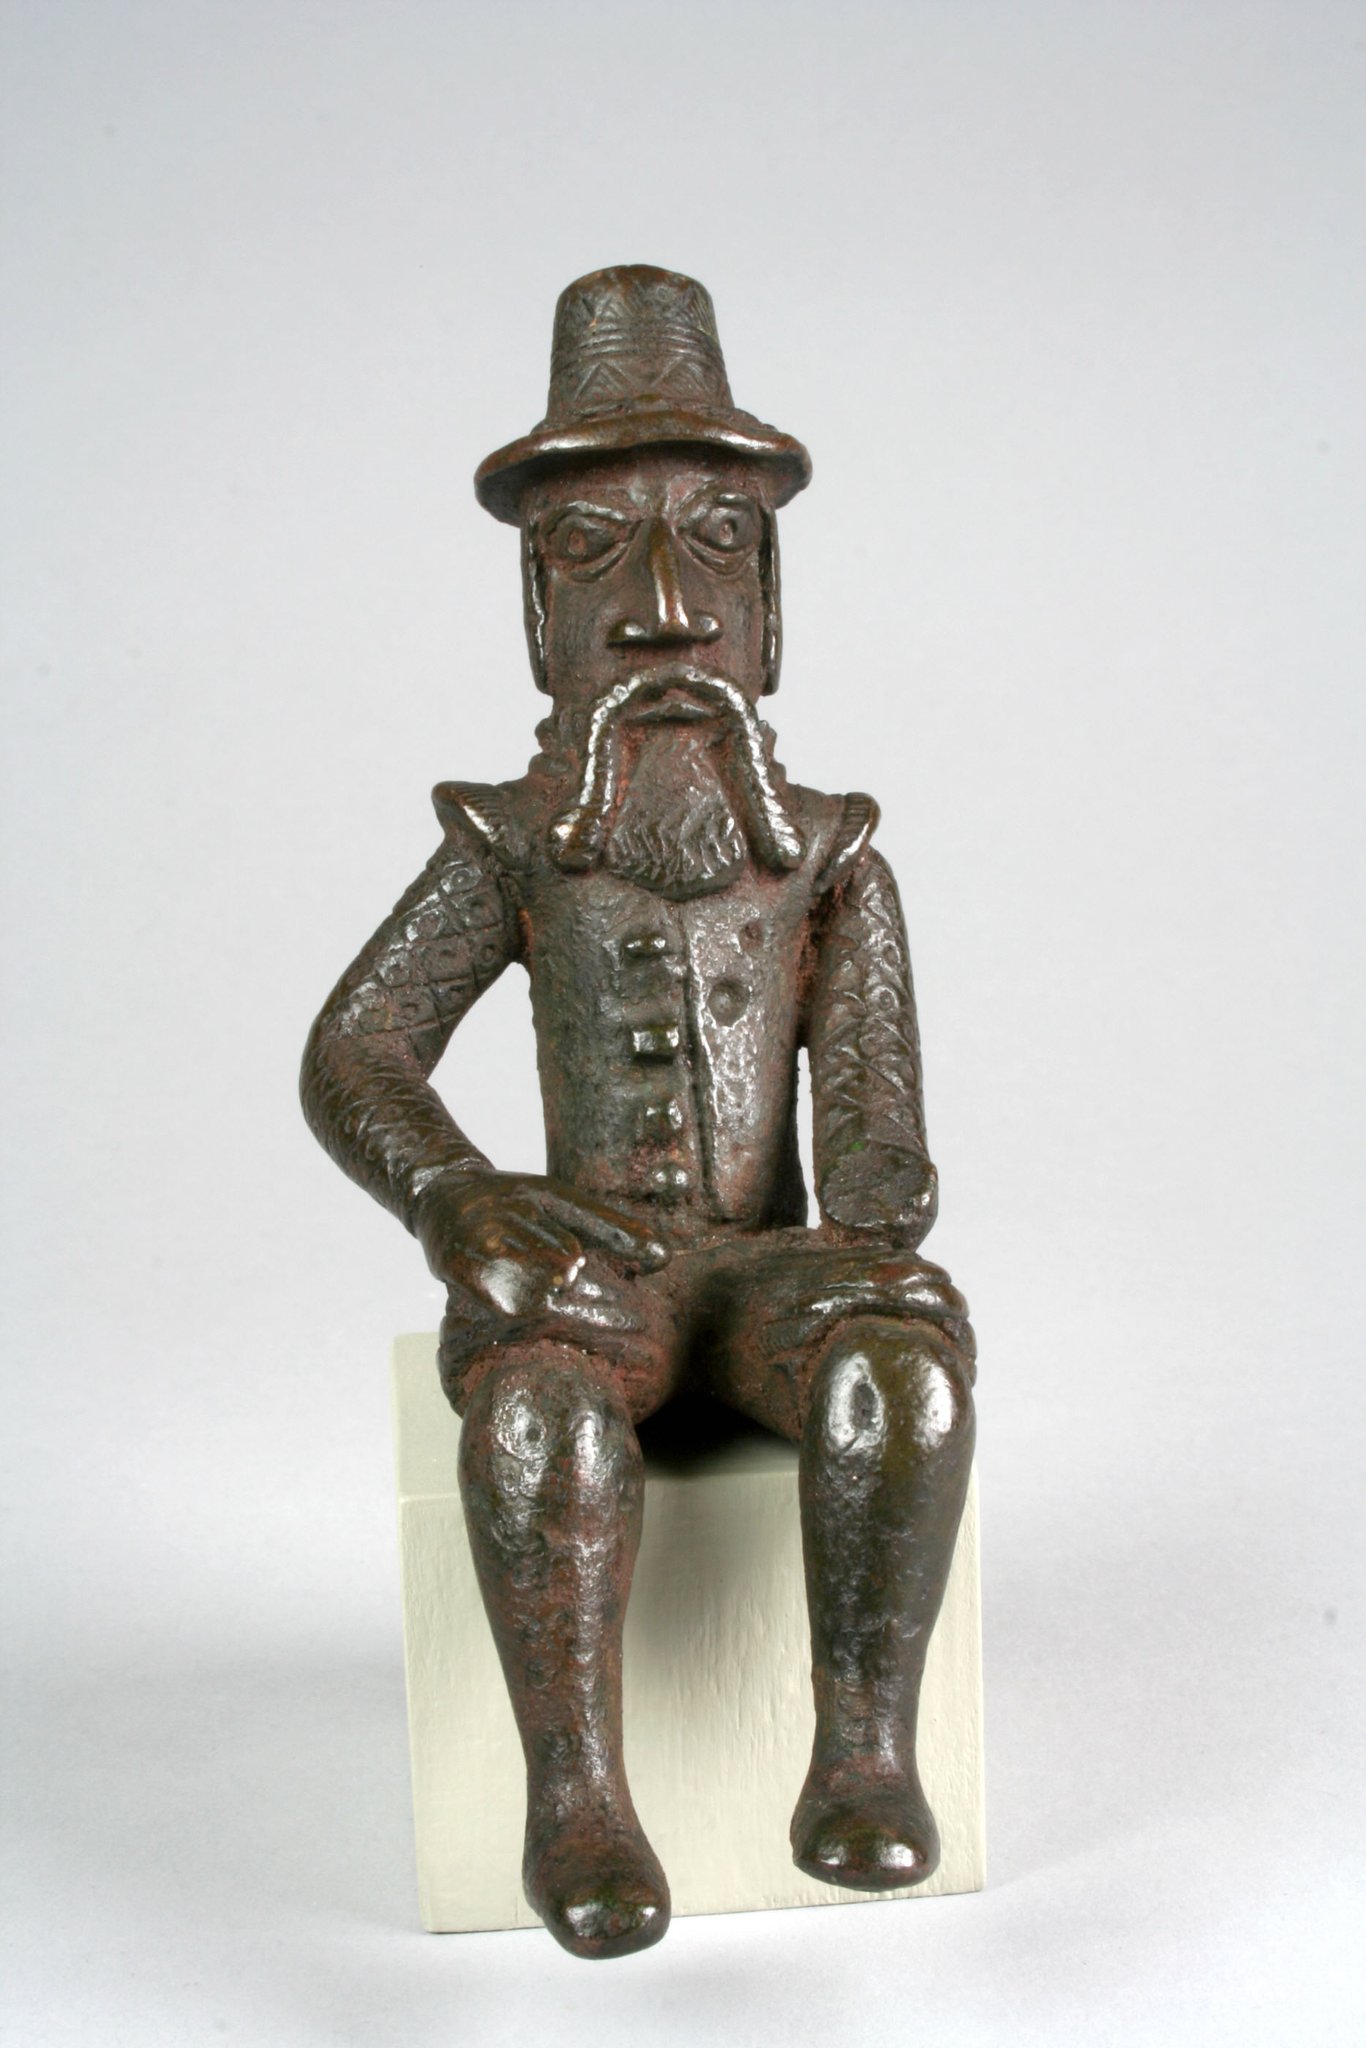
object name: male figure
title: Figure: Seated Portuguese Male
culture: edo period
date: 1701-1800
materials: brass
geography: nigeria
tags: men